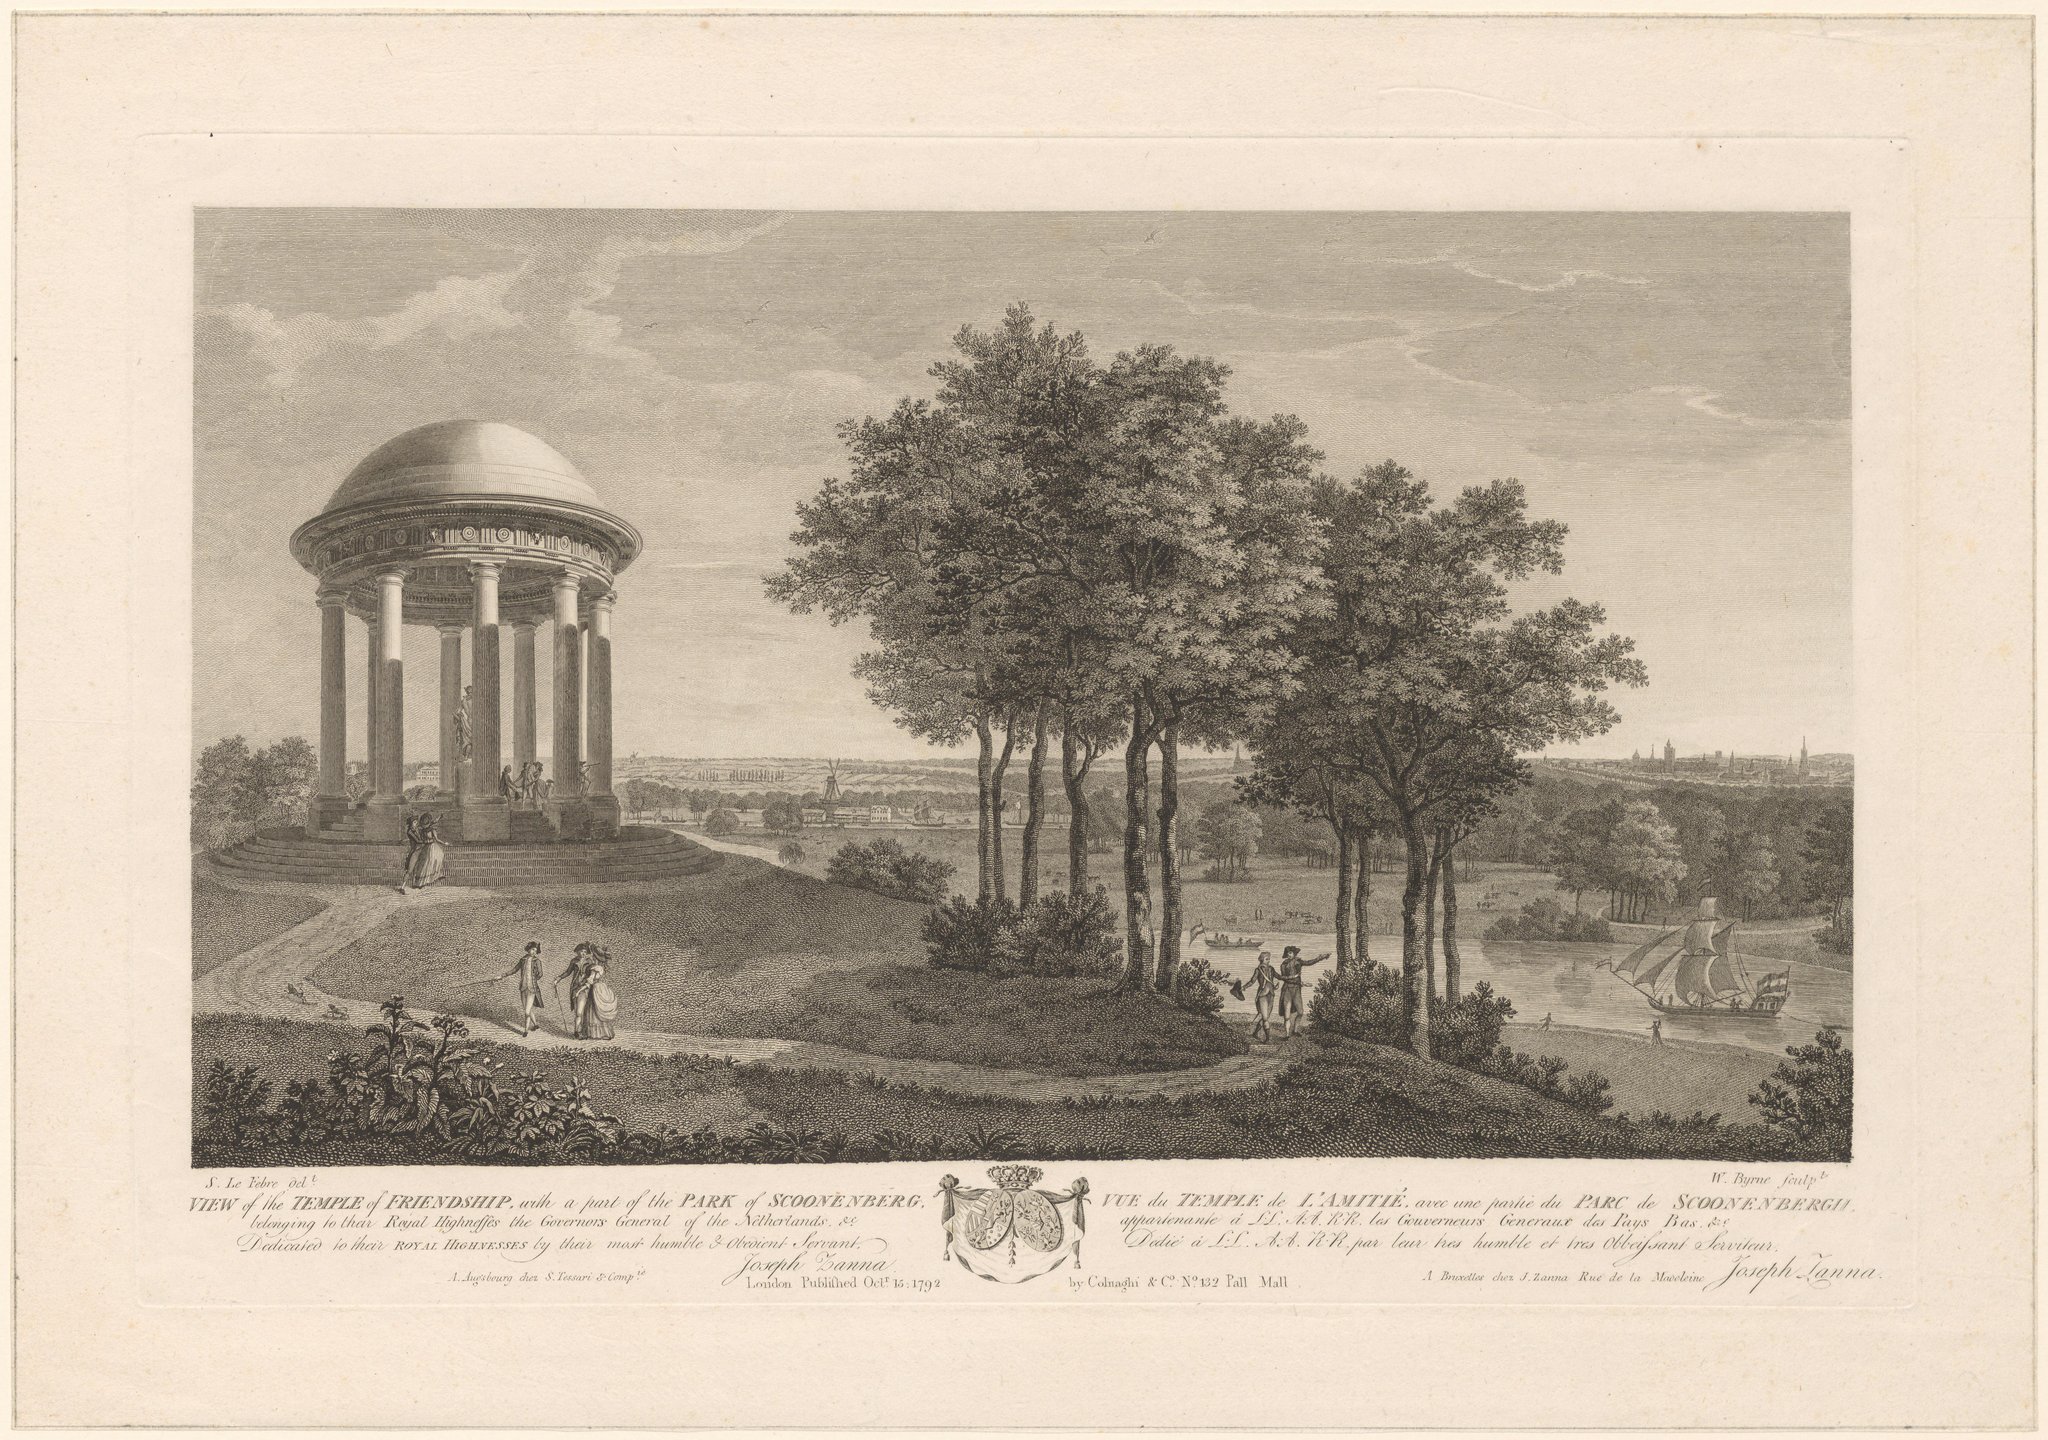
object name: print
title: View of the Temple of Friendship, with a part of the Park of Scoonenberg (...) / Vue du Temple de L'Amitié (...)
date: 1710-1792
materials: paper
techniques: etching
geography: brussels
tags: sailing-ship, sailing-boat, walking, hiking (recreation), river, garden ornaments, laeken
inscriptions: collector's mark: Lugt 2233